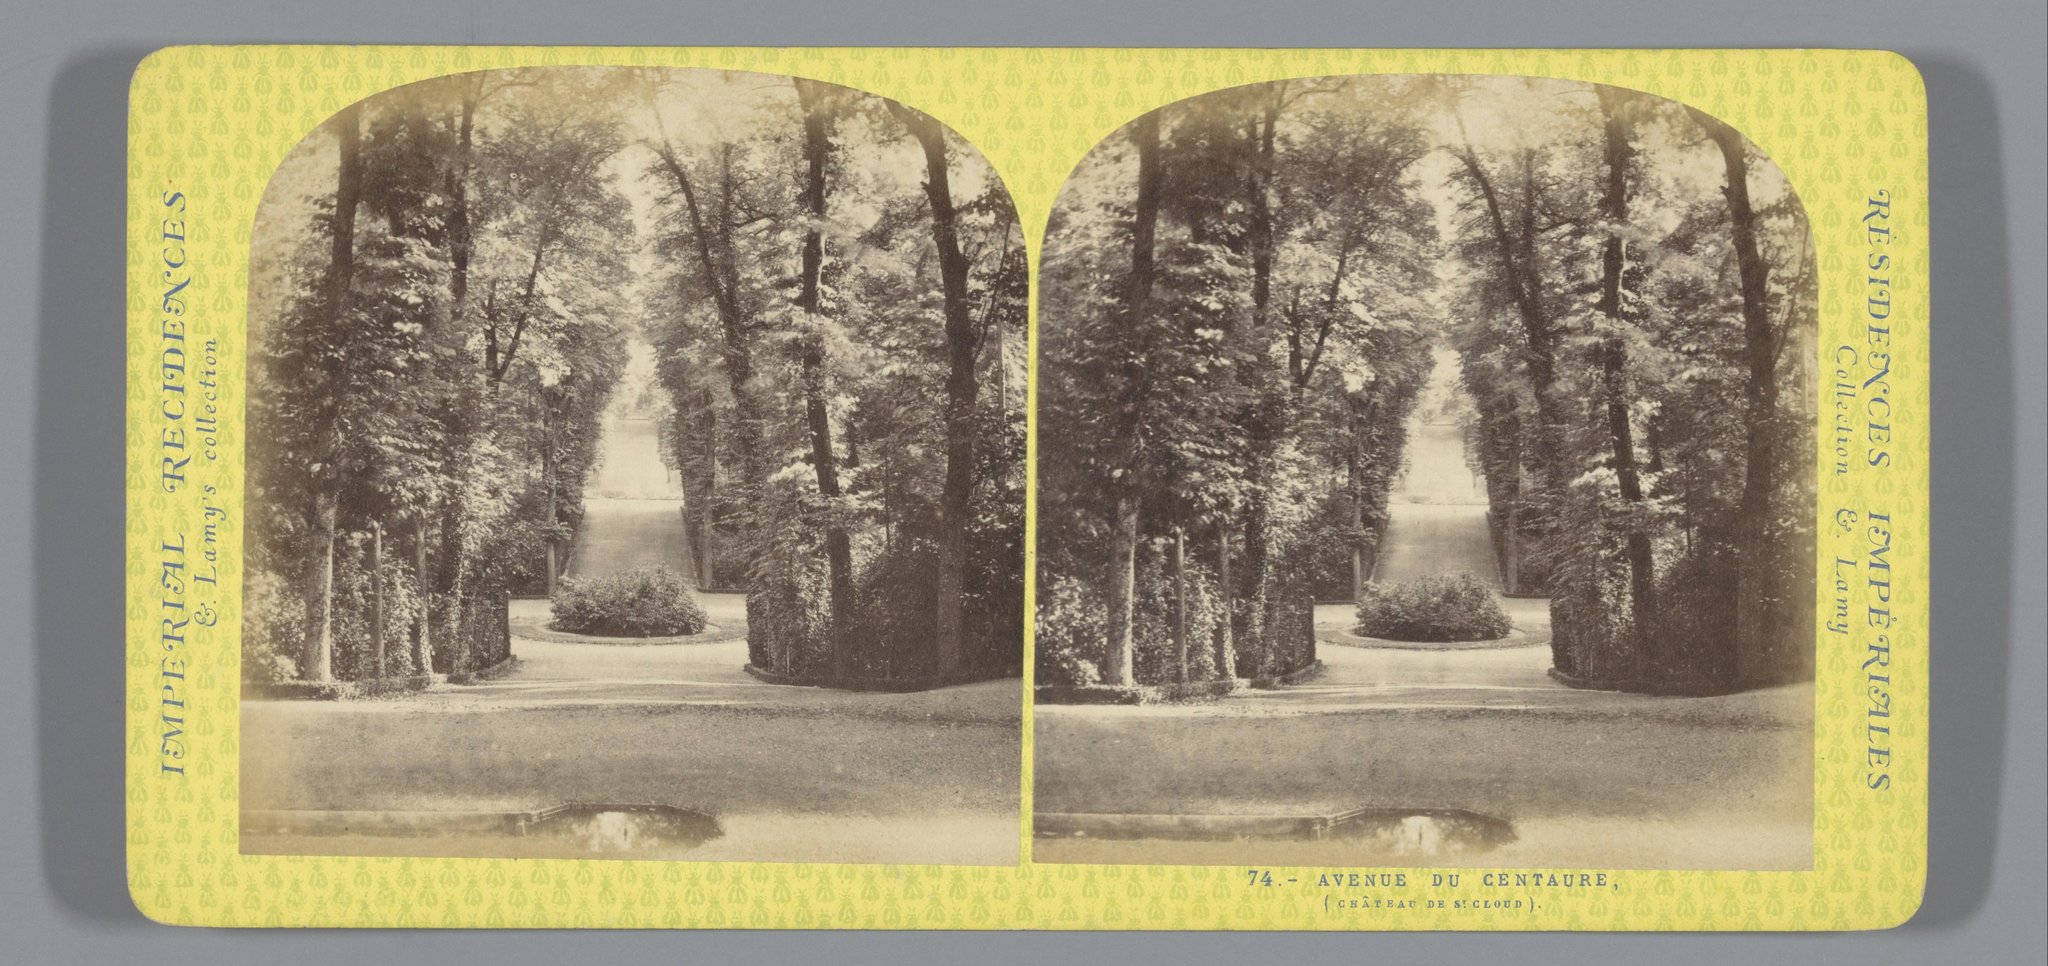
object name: stereograph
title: Gezicht op de Avenue du Centaure in het Parc de Saint-Cloud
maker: ernest eléonor pierre lamy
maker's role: publisher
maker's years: 1828-1900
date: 1860-1870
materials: cardboard, photographic support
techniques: albumen print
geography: parc de saint-cloud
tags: garden, lane, alley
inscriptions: number: ‘74.’, inscription: ‘E. Lamy's collection’